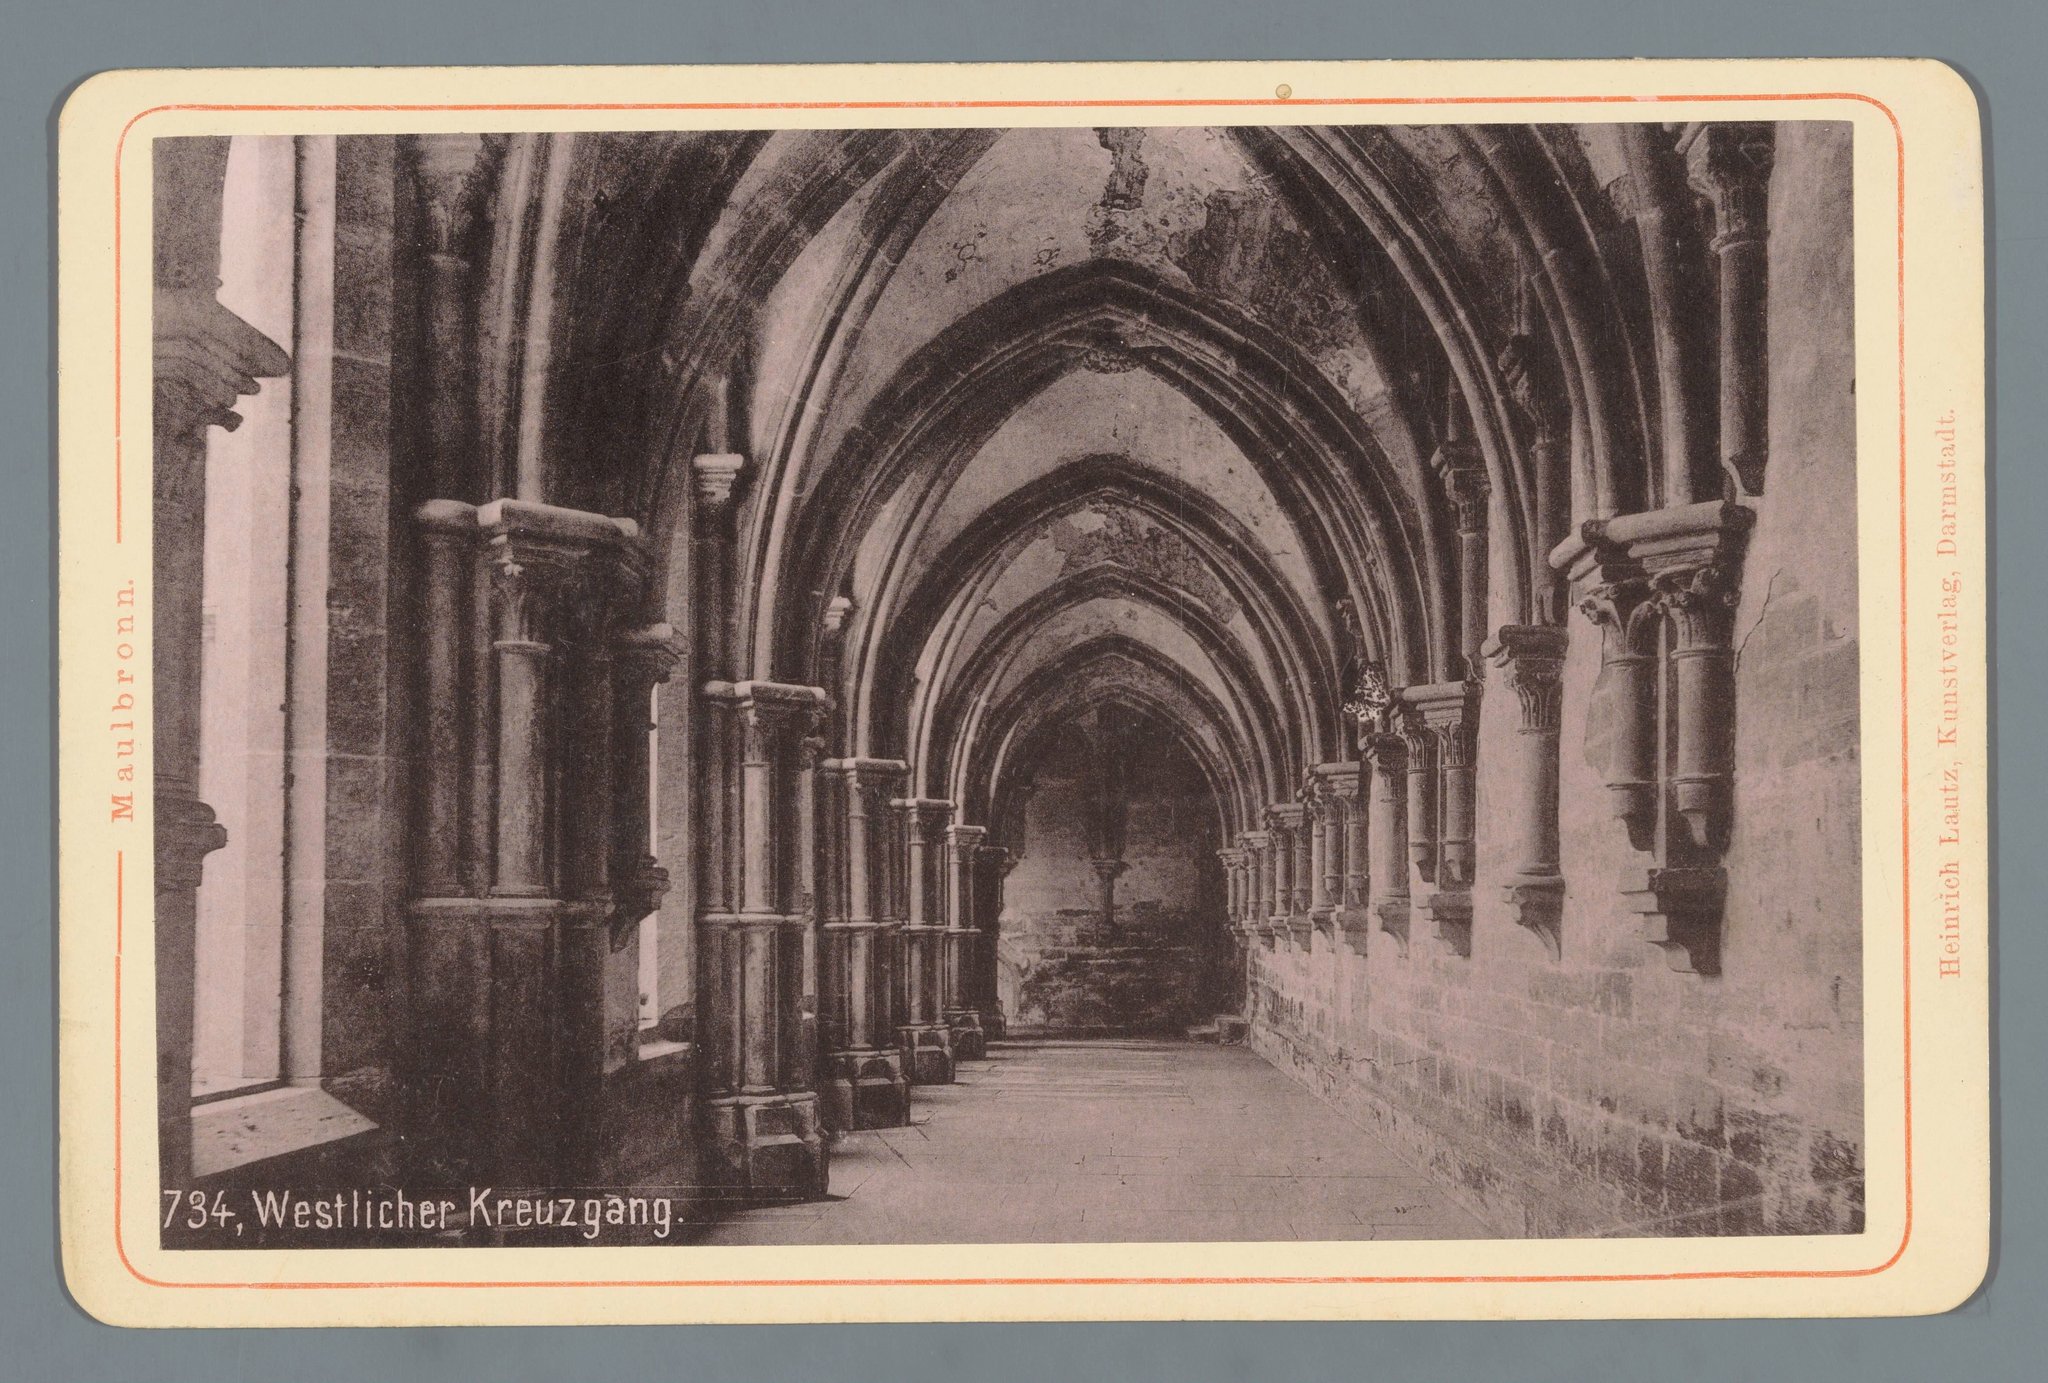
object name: photomechanical print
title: Kloostergang in de Abdij van Maulbronn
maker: Anonymous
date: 1895-1900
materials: cardboard, paper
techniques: photograph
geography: darmstadt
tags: abbey, monastery, convent ~ roman catholic church, cloisters ~ monastery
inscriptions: number: ‘734’, inscription: ‘17 Juli 1894’